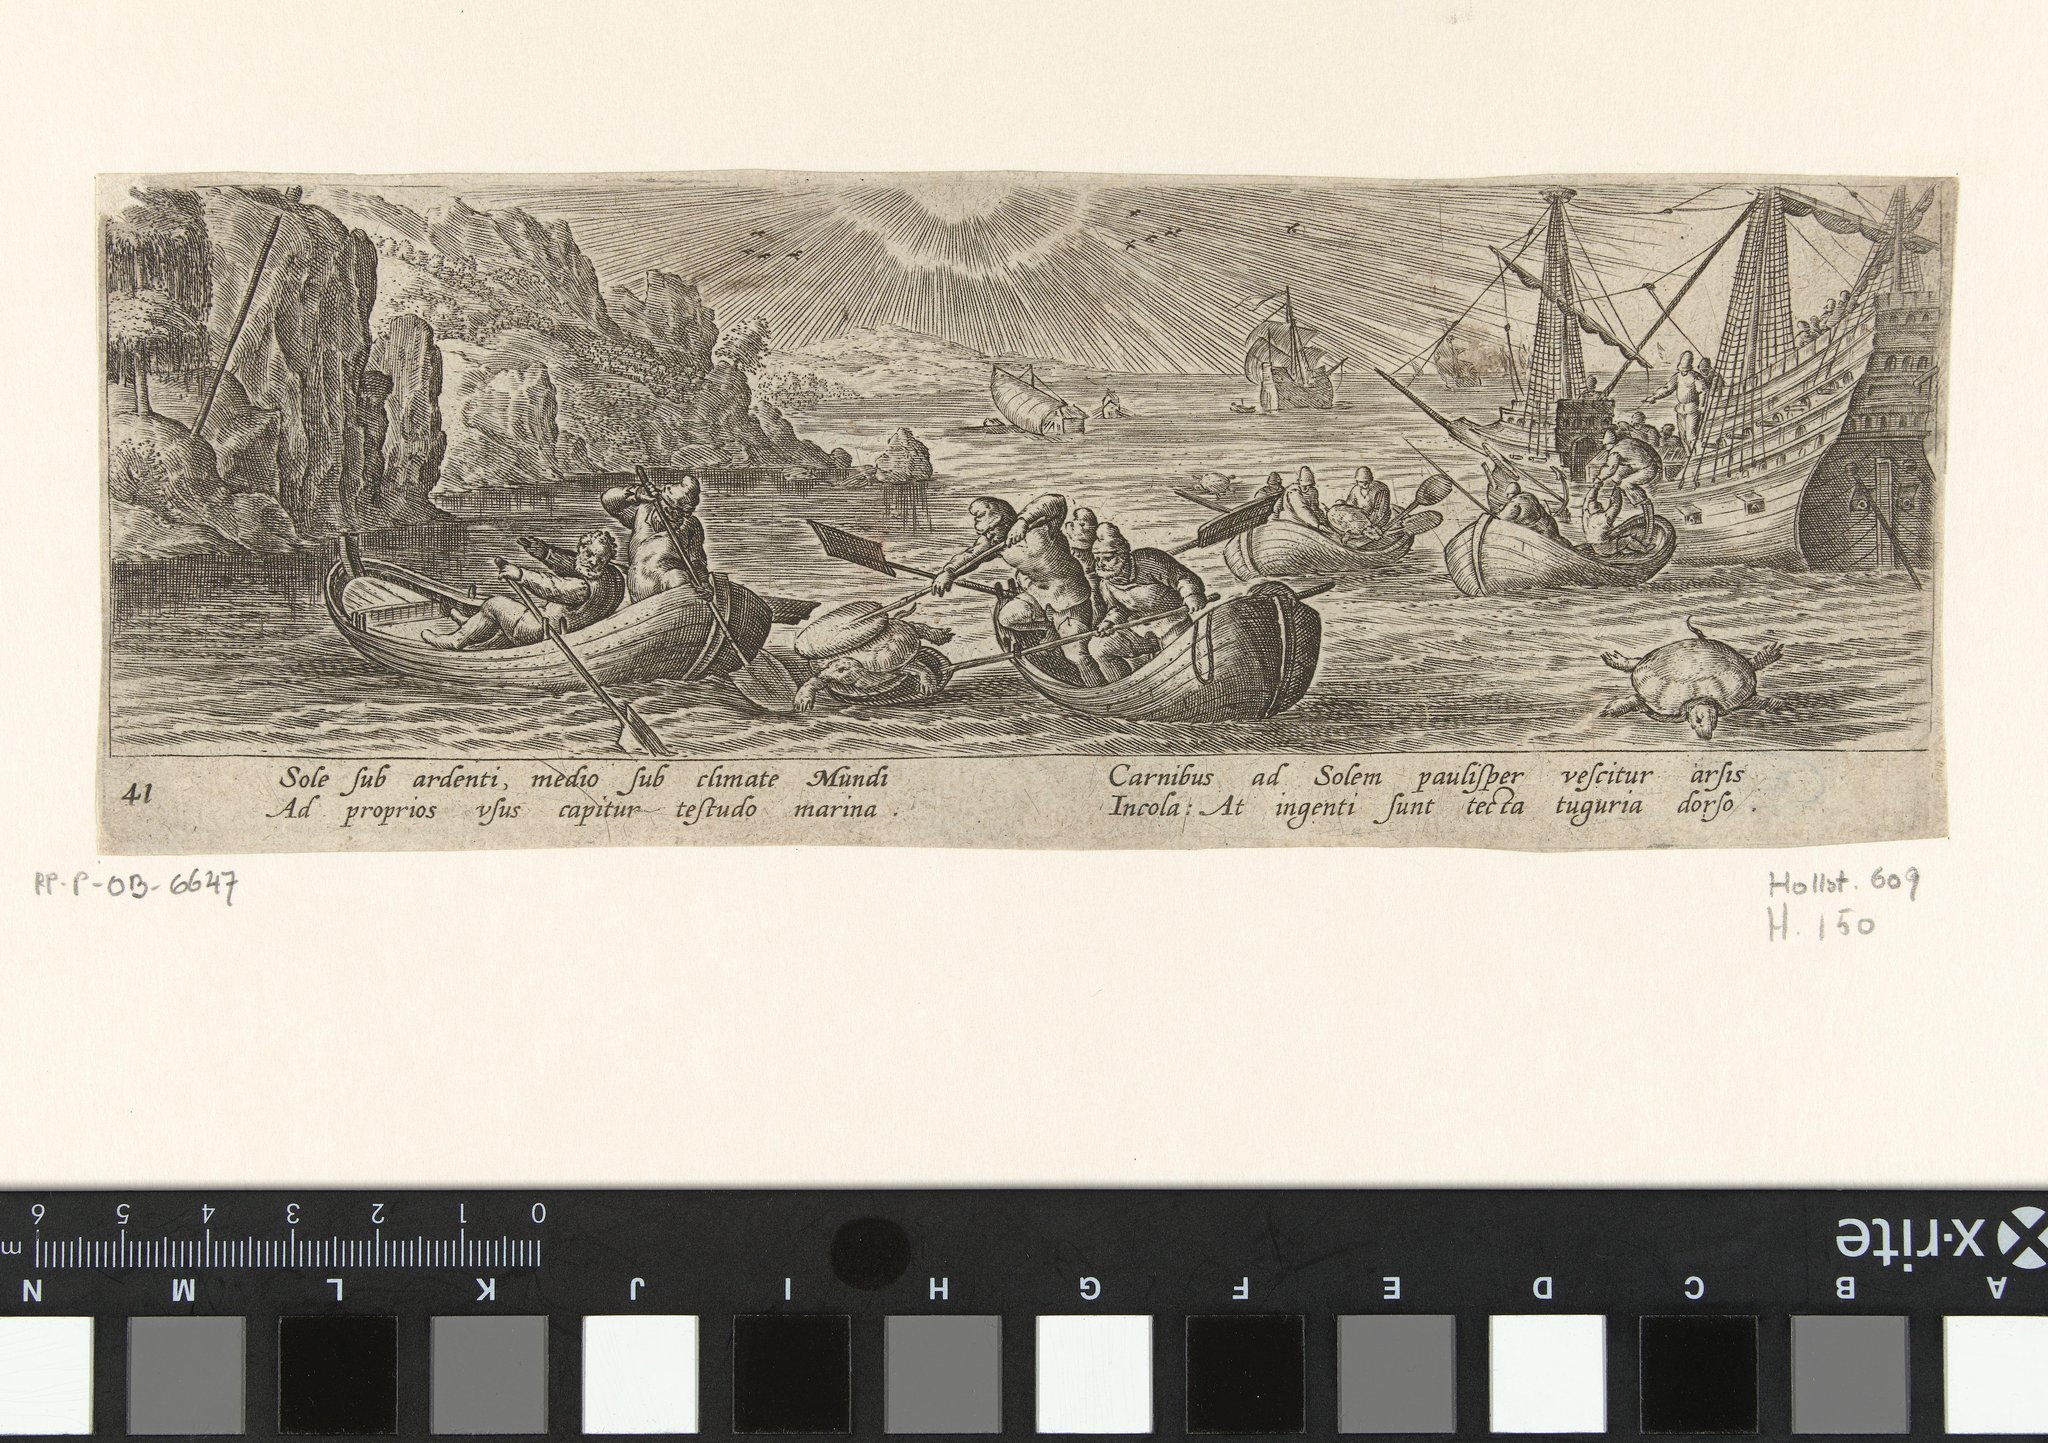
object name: print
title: Jacht en visvangst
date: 1582-1633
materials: paper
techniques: engraving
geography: antwerp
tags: tortoises, turtles, hunt ~ other animals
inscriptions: collector's mark: Lugt 2228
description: Vissers in roeiboten trachten een zeeschildpad te vangen met hun roeispanen. De prent heeft een Latijns onderschrift en maakt deel uit van een serie van 54 prenten.